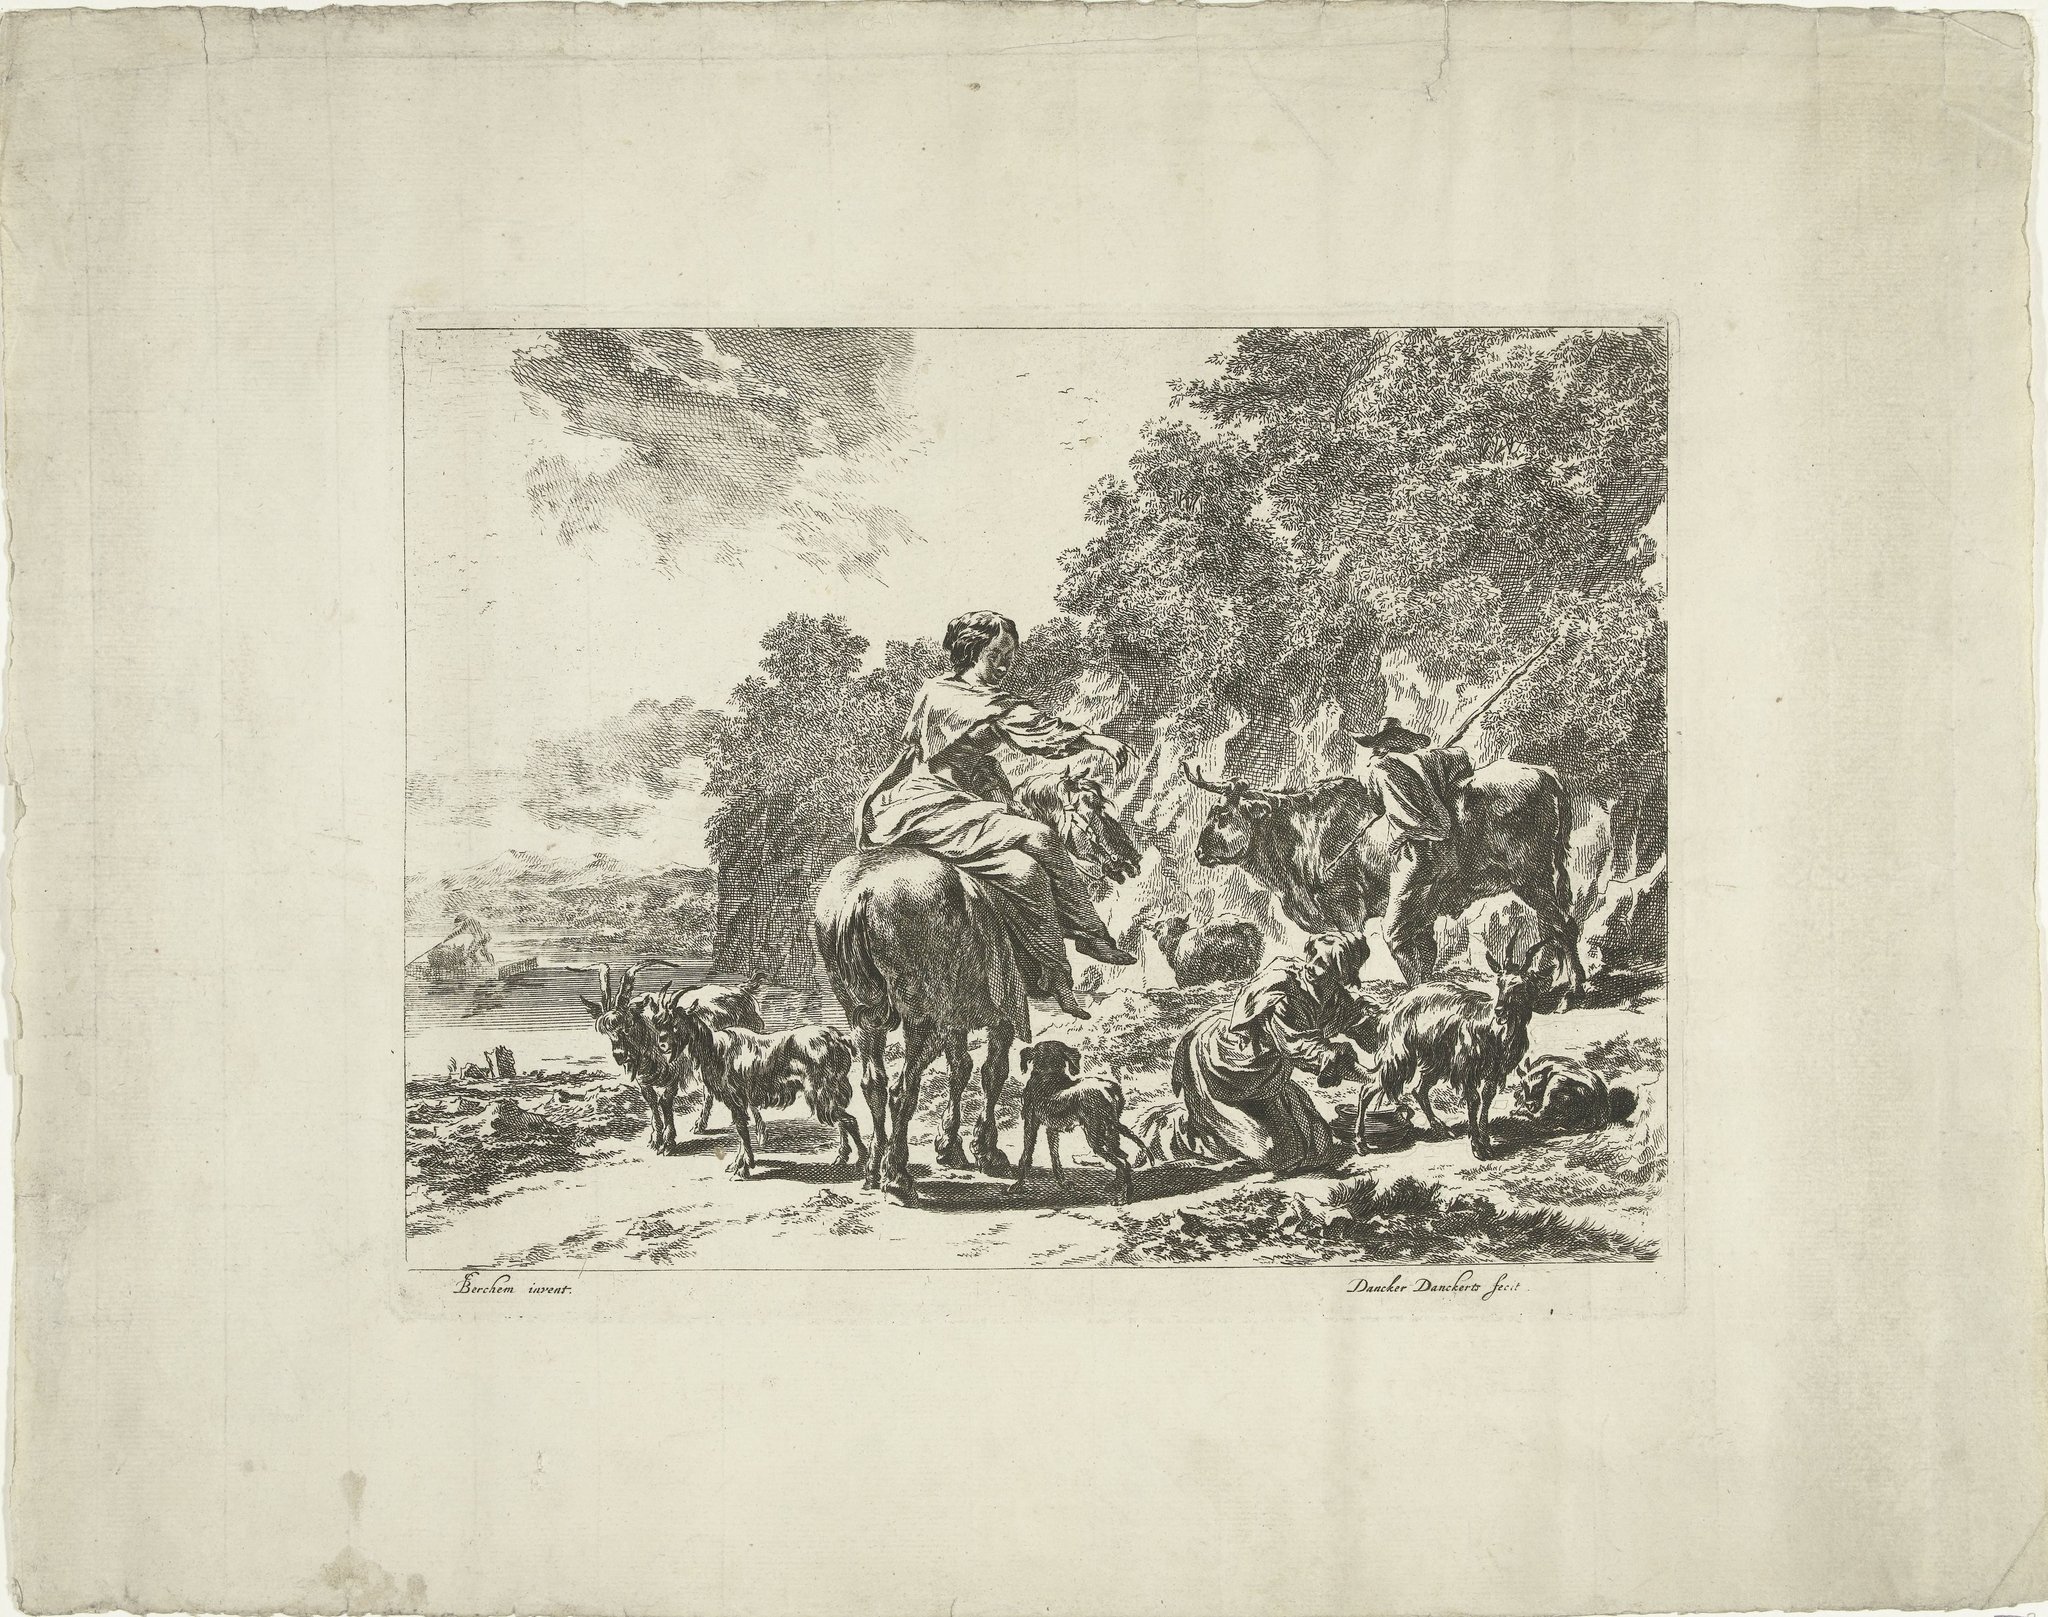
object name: print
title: Zuidelijke landschappen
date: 1643-1666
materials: paper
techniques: etching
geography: amsterdam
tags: herding, herdsman, herdswoman, shepherd, shepherdess, cowherd, etc., goat, rocks, milking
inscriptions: collector's mark: Lugt 2228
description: Prent uit serie van zes landschappen naar ontwerp van Nicolaes Pietersz. Berchem. Deze vierde staat van de laatste prent uit de reeks wordt niet bij Hollstein beschreven, achter de naam van Danckerts ontbreekt het woord excudit.